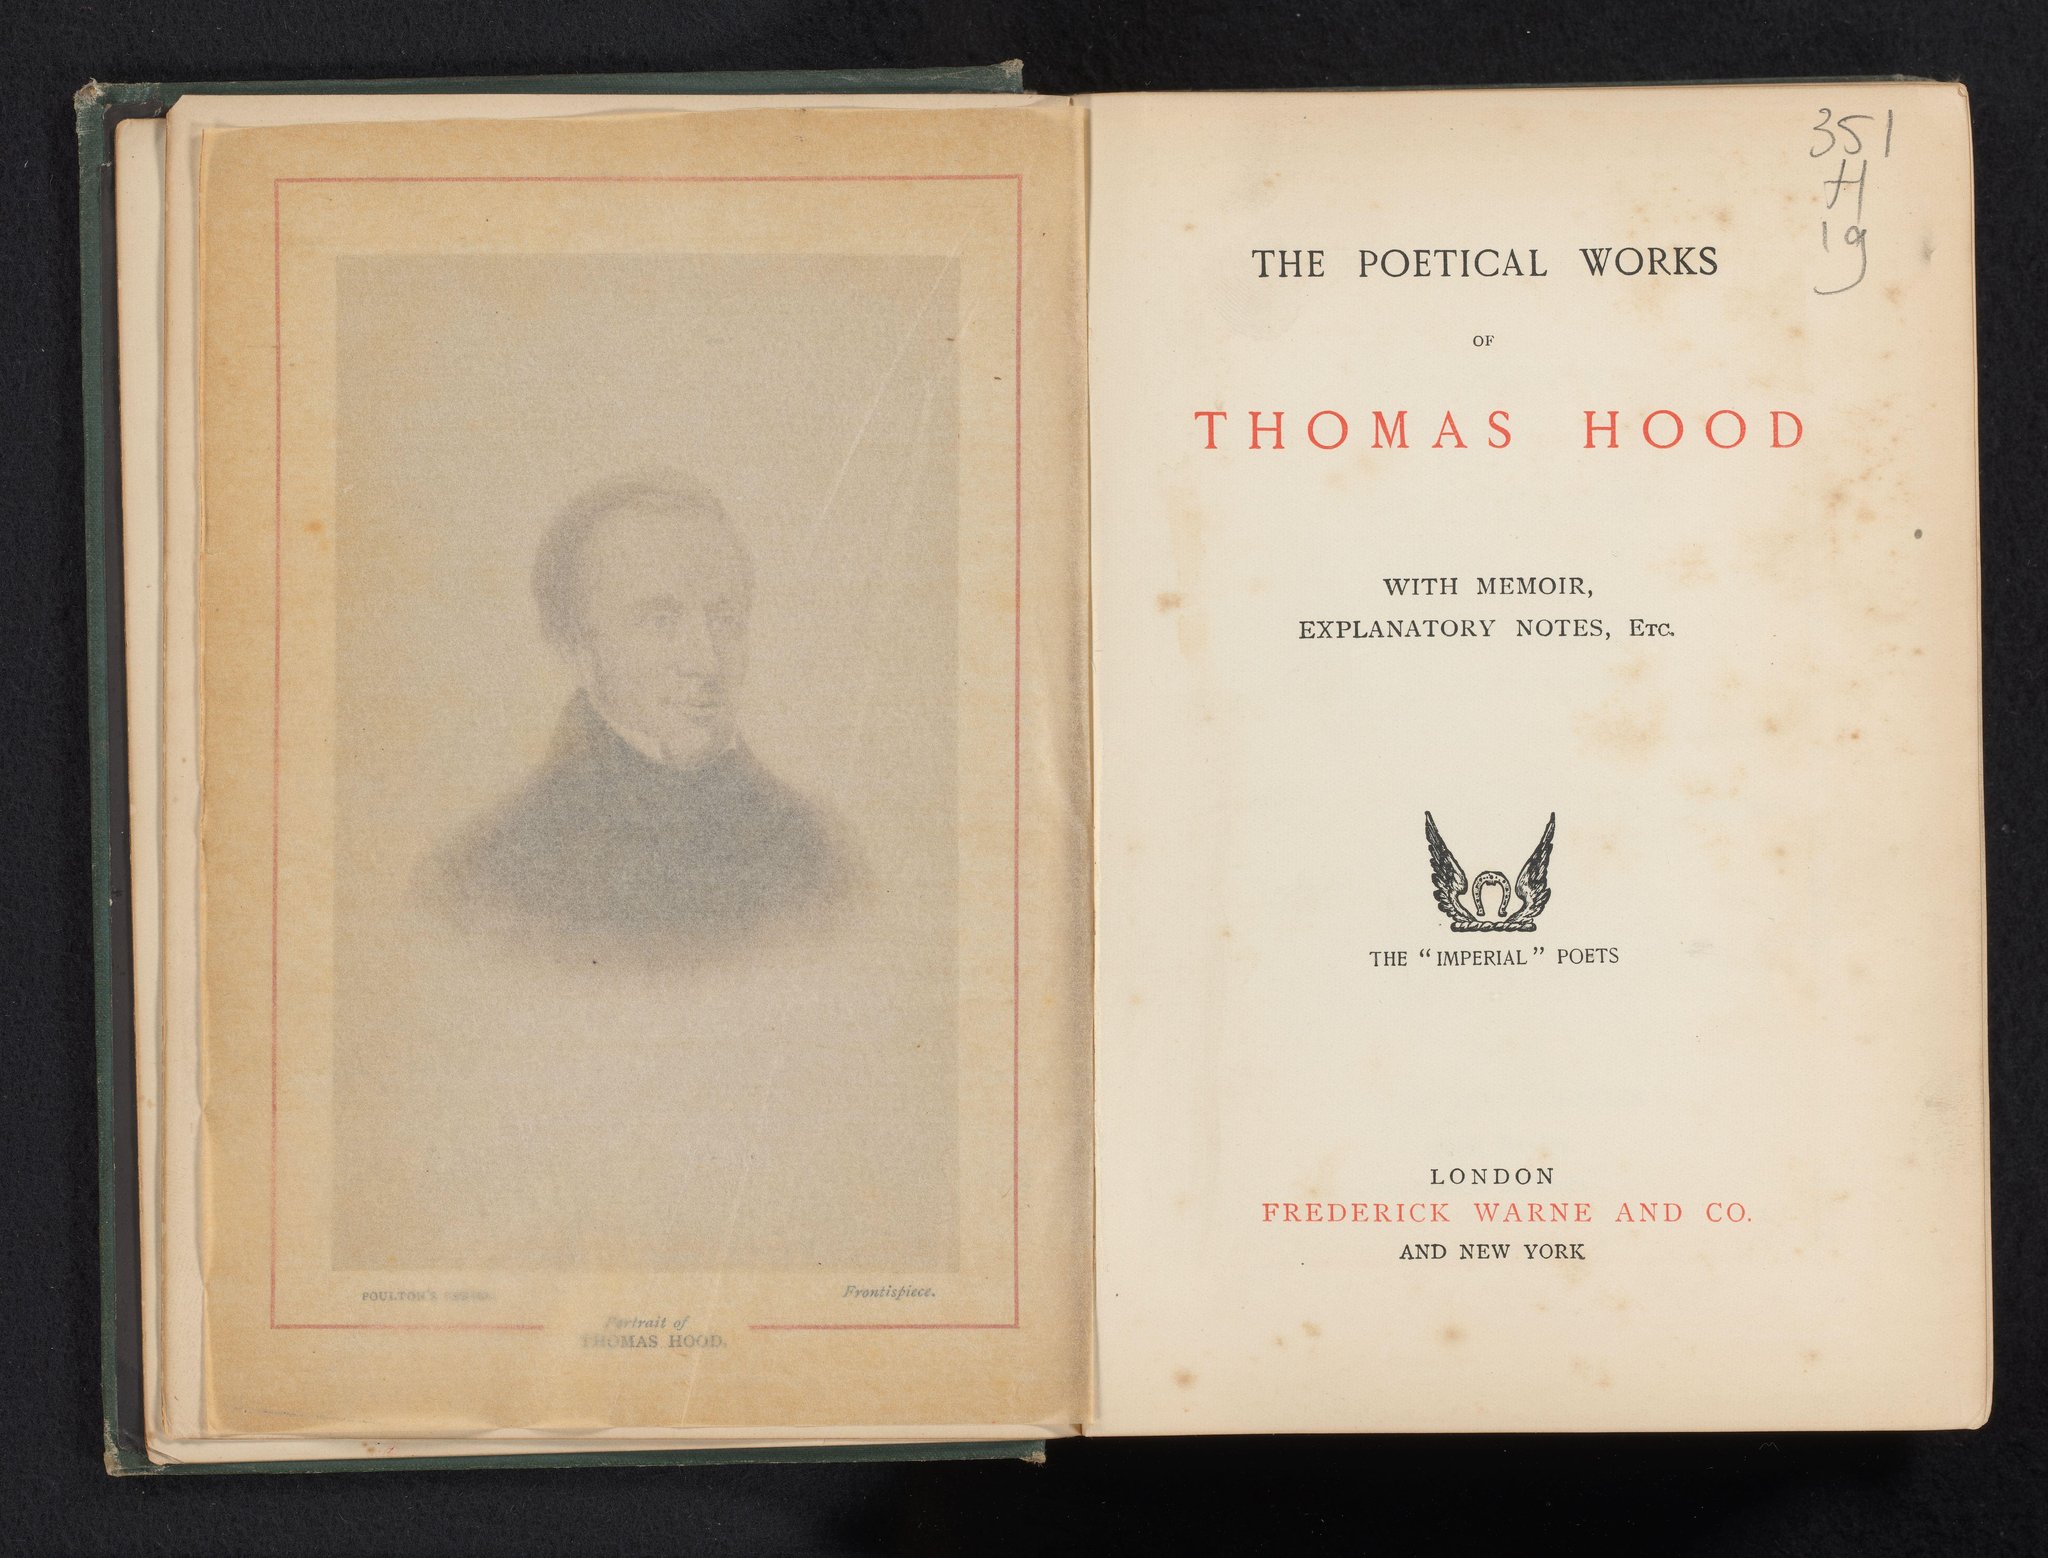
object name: book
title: The poetical works of Thomas Hood : with memoir, explanatory notes, etc.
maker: thomas hood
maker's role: dichter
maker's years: 1799-1845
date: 1870-1890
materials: cardboard, linen, paper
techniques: albumen print, letterpress printing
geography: london